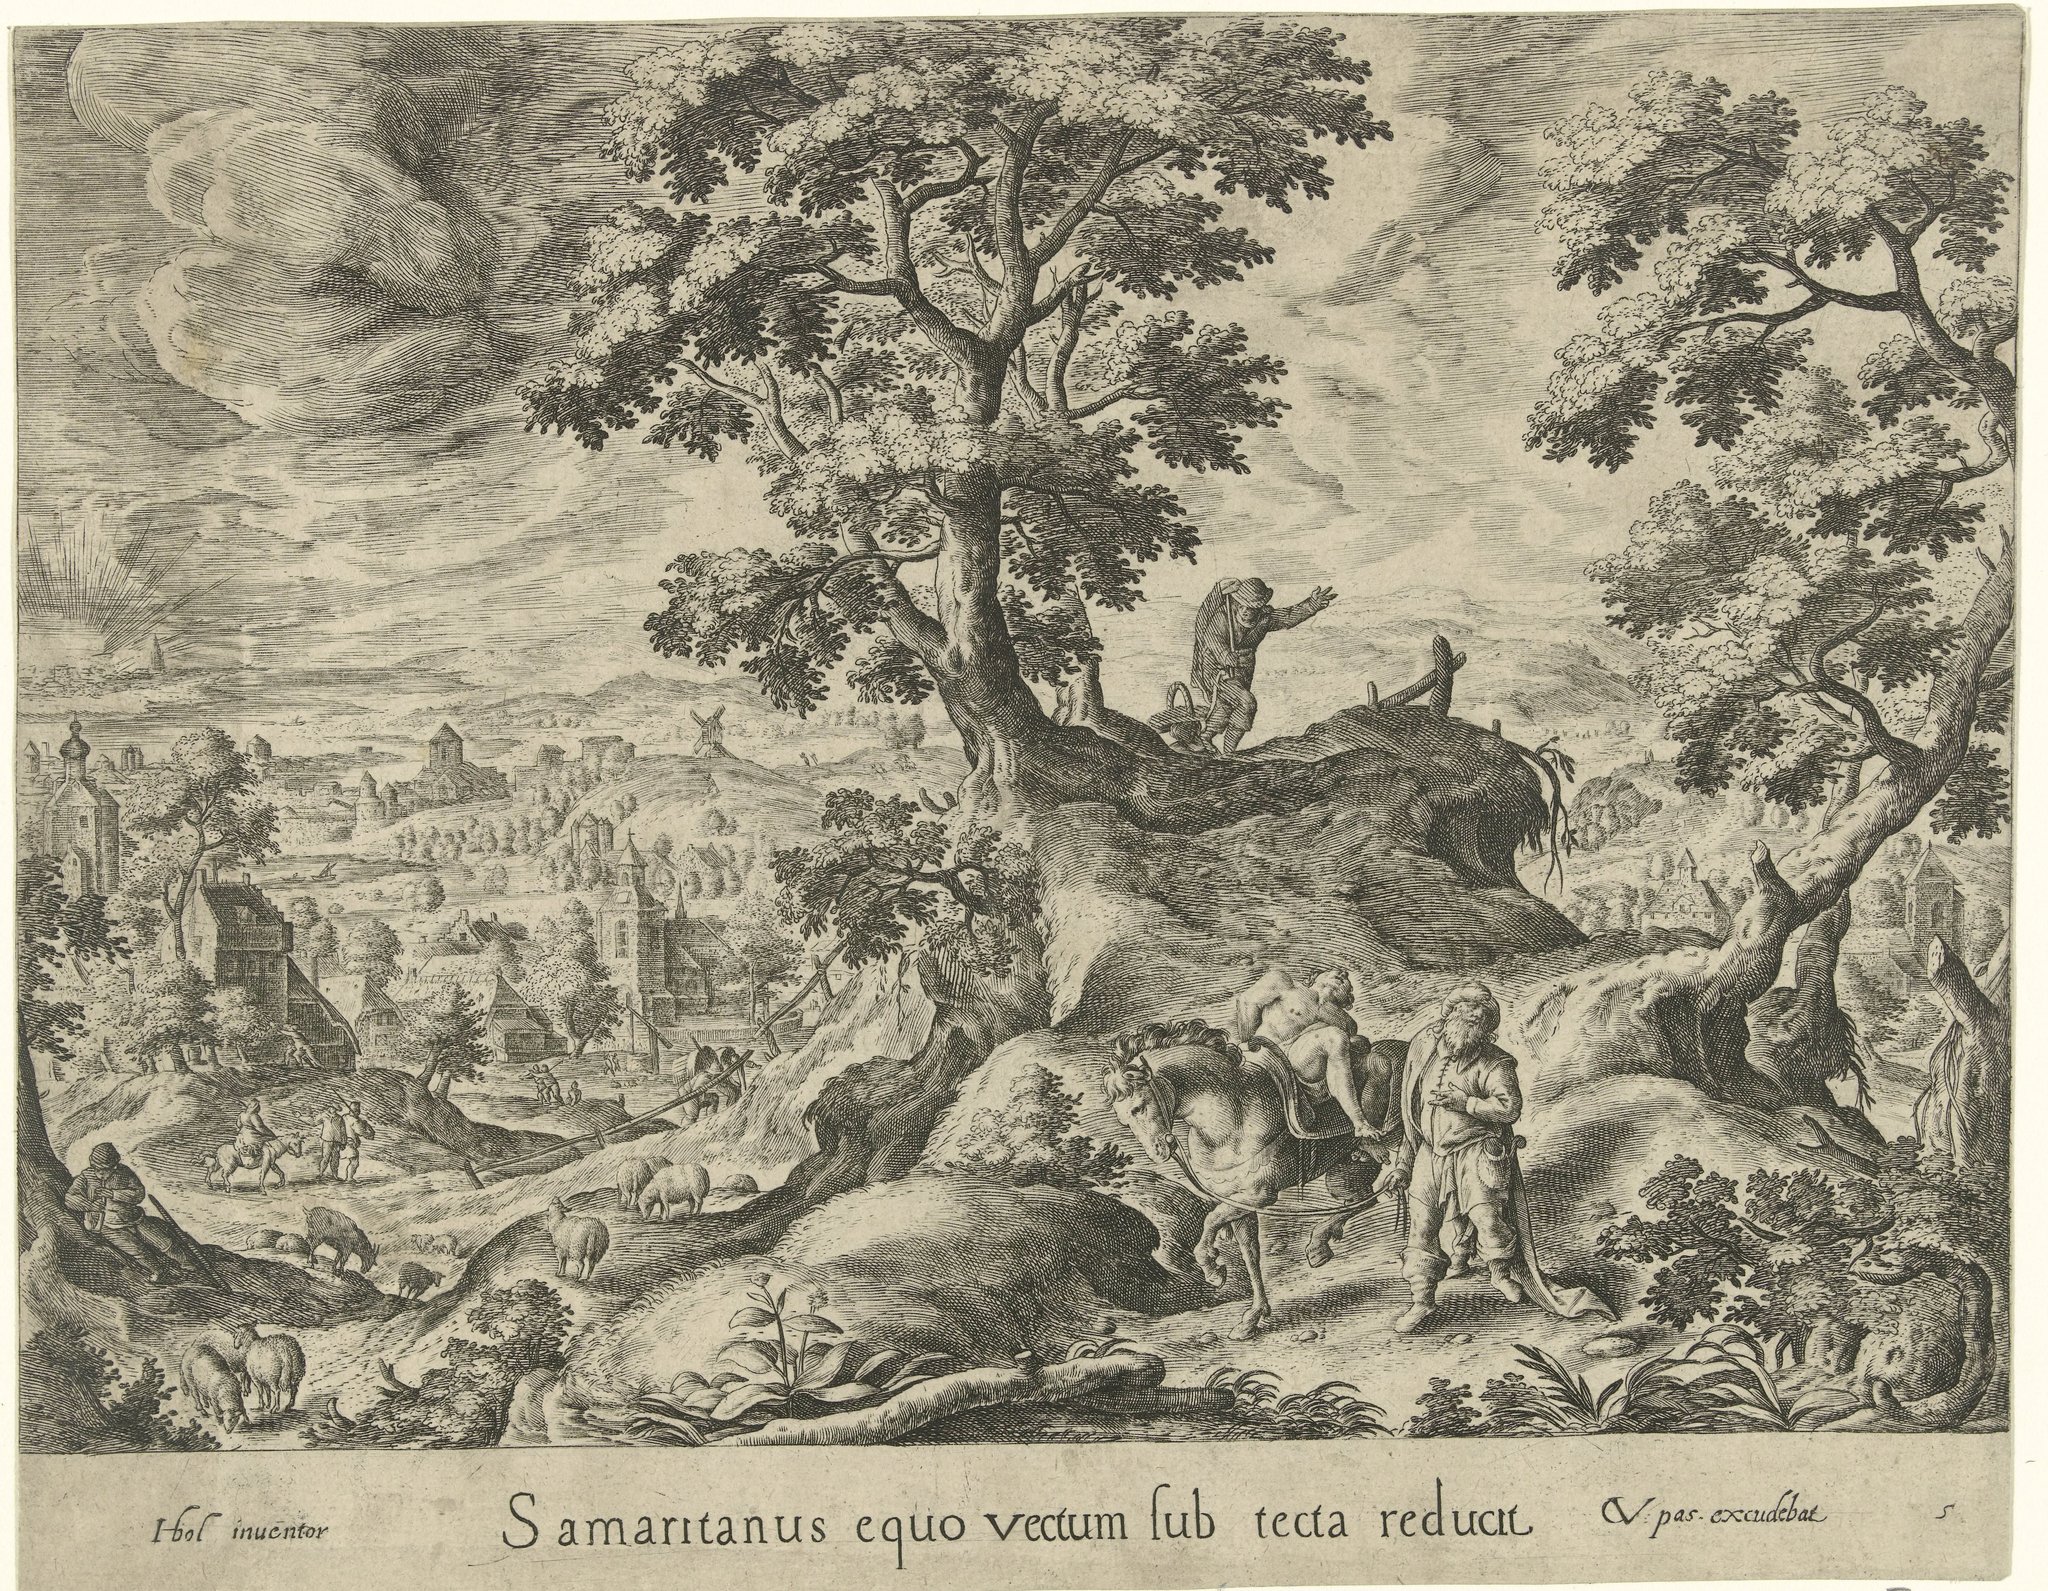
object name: print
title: Landschappen met scènes uit de gelijkenis van de barmhartige Samaritaan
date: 1588-1589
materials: paper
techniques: engraving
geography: aachen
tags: the samaritan sets the wounded traveller on his mount (ass or horse), and brings him to an inn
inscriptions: collector's mark: Lugt 2228, collector's mark: Lugt 1337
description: De barmhartige Samaritaan vervoert de gewonde reiziger op zijn paard. In de marge een regel in het Latijn.